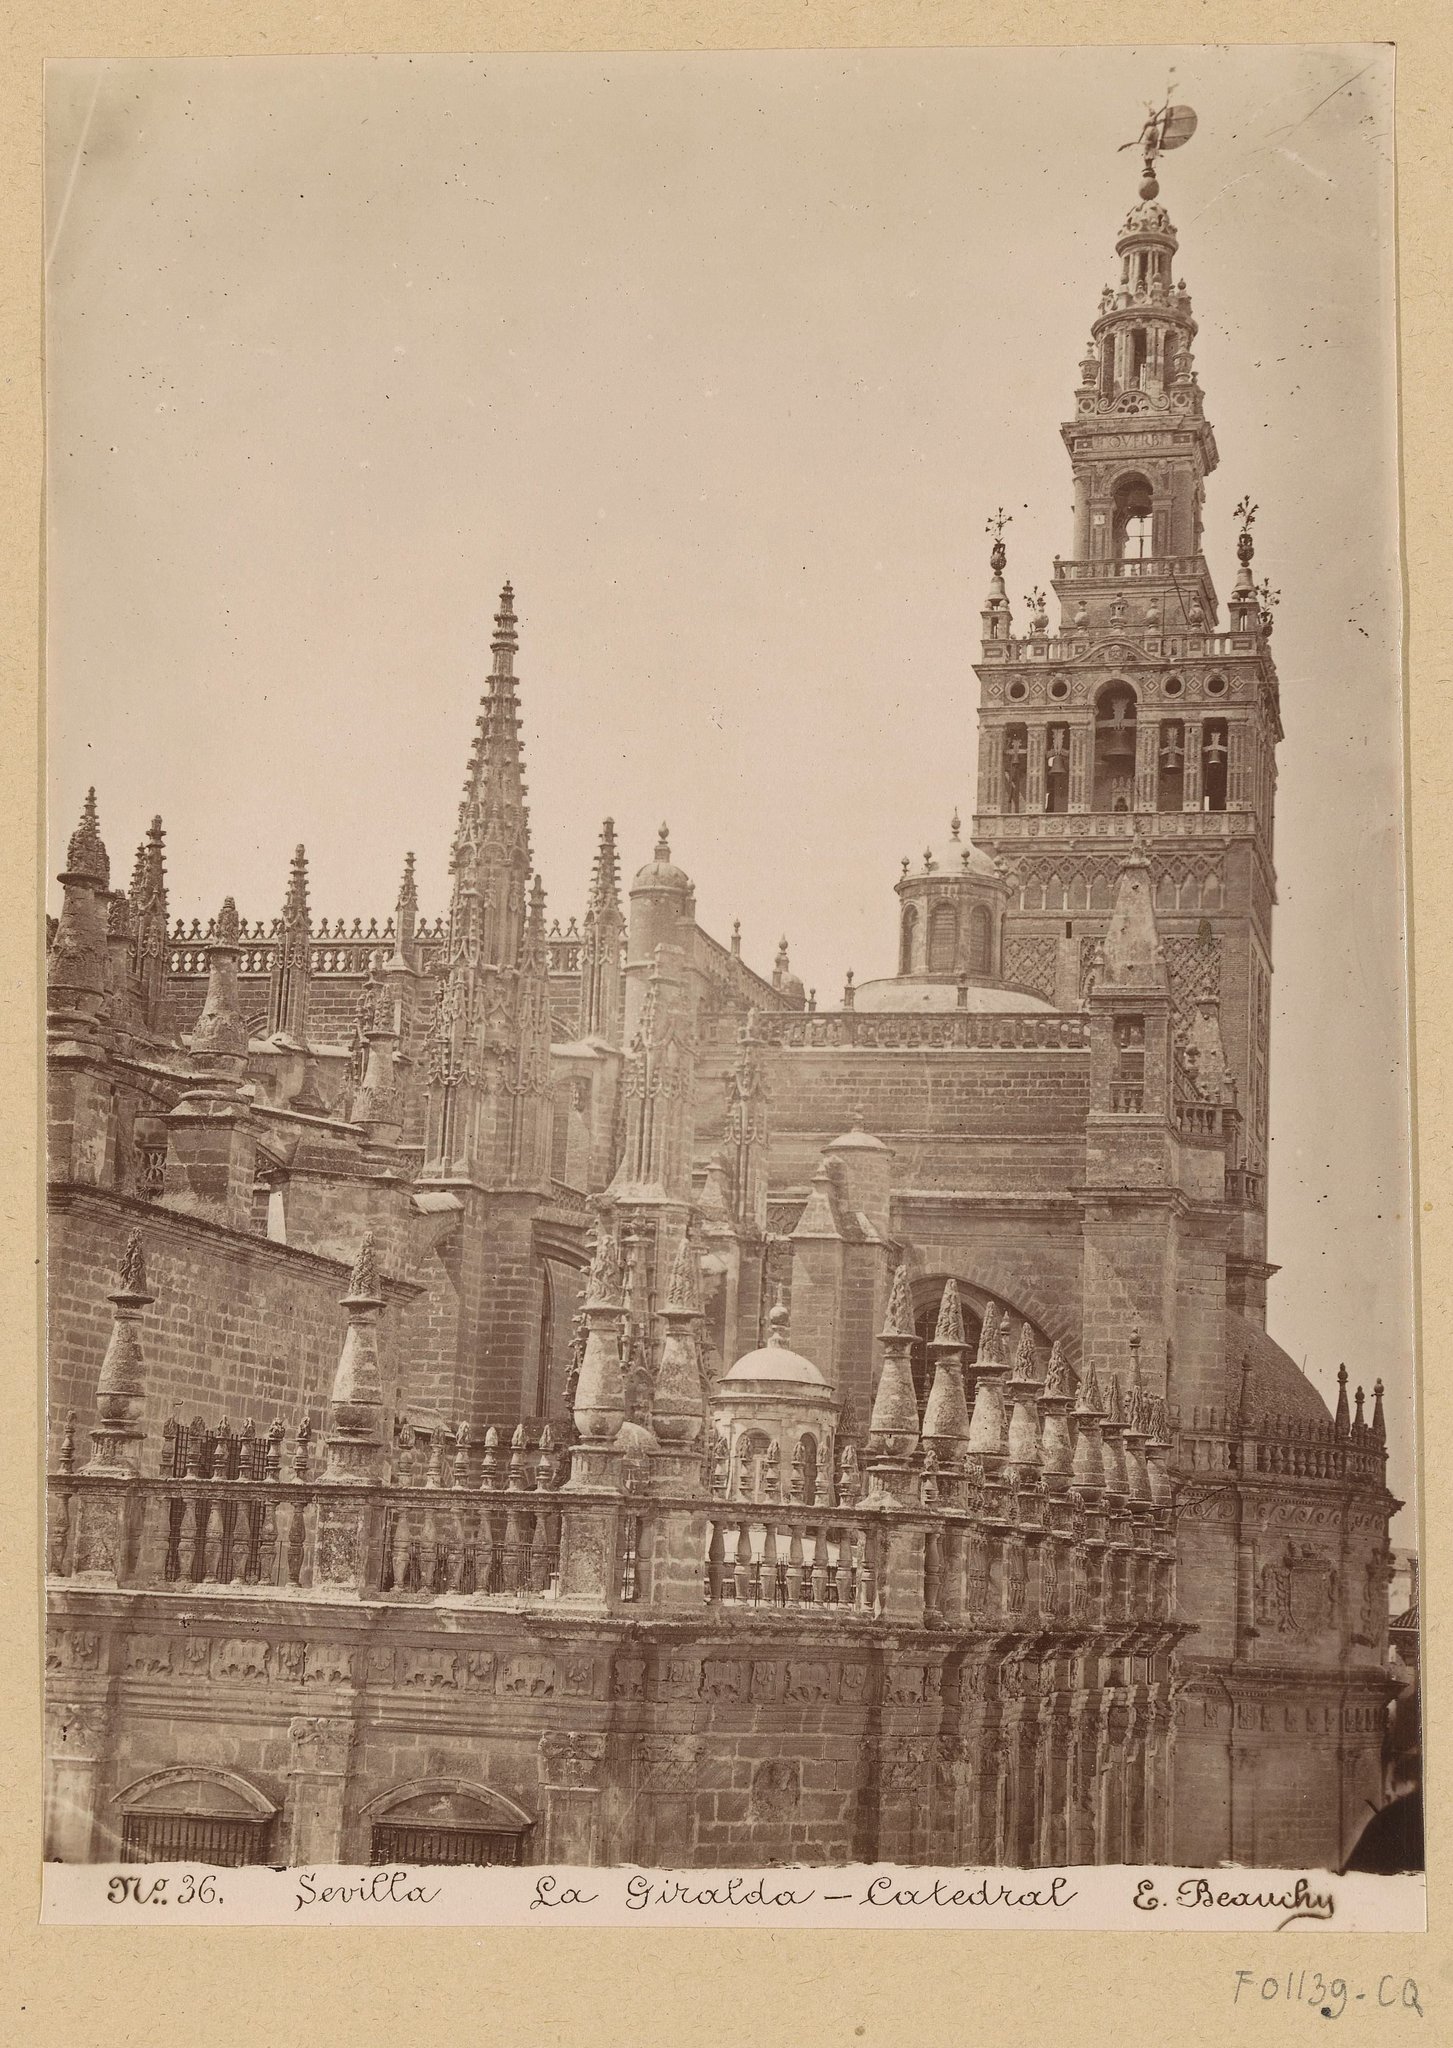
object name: photograph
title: Gezicht op de Giralda nabij de kathedraal van Sevilla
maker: emilio beauchy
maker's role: fotograaf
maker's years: 1847-1928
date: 1880-1888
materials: paper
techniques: albumen print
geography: sevilla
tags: church (exterior)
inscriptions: number: ‘No.. 36.’